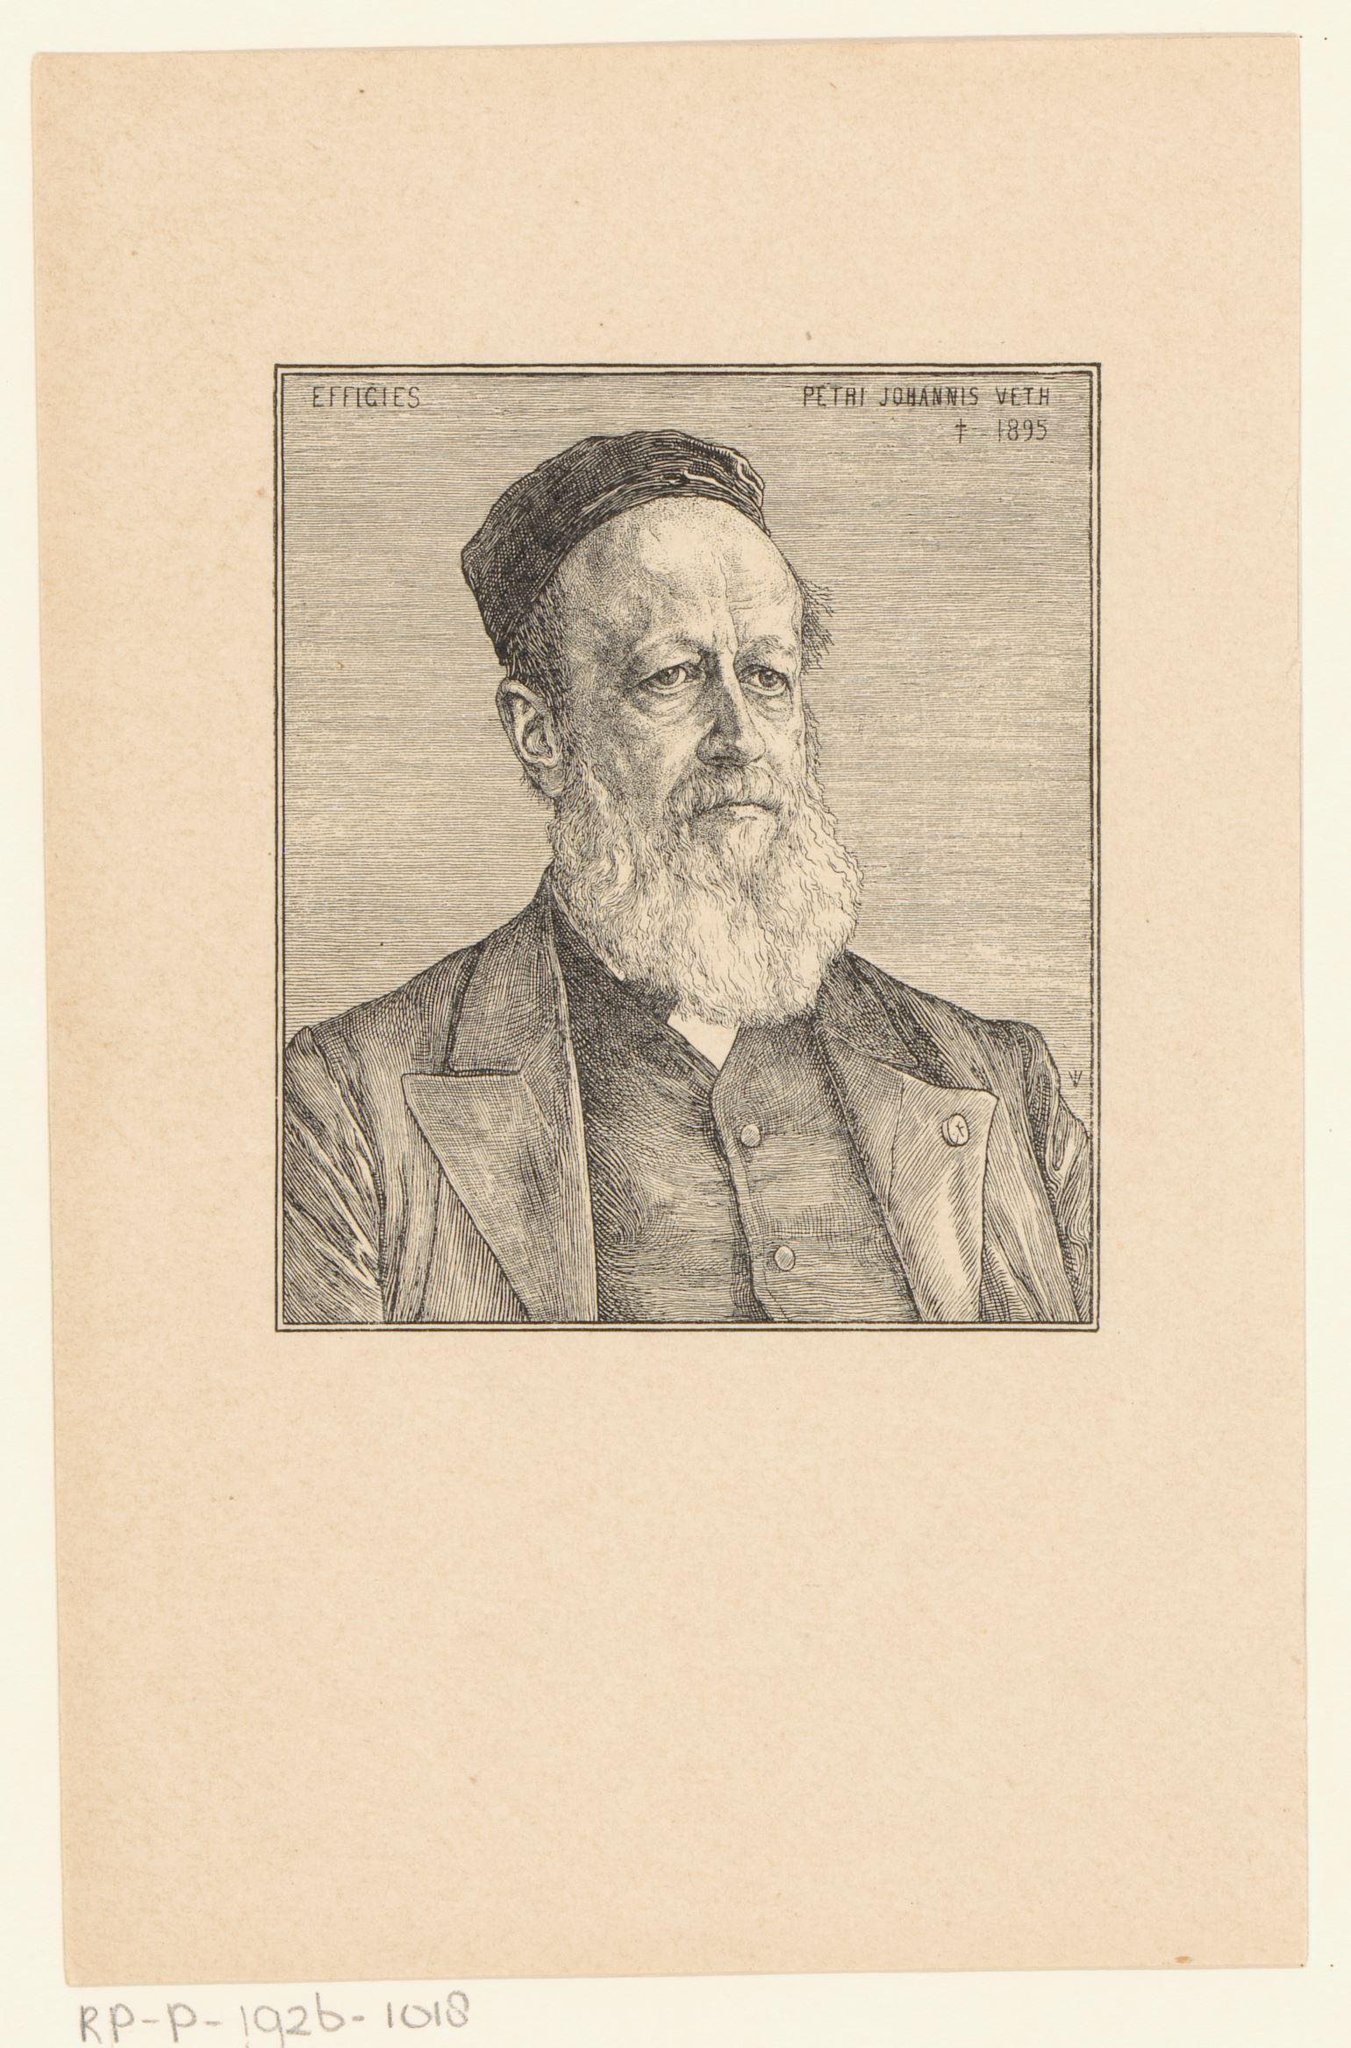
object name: print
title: Portret van Pieter Johannes Veth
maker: Anonymous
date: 1895-1926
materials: paper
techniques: lithograph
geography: netherlands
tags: dordrecht, historical persons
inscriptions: collector's mark: Lugt 2228, collector's mark: ‘H.G. Samson Amsterdam’